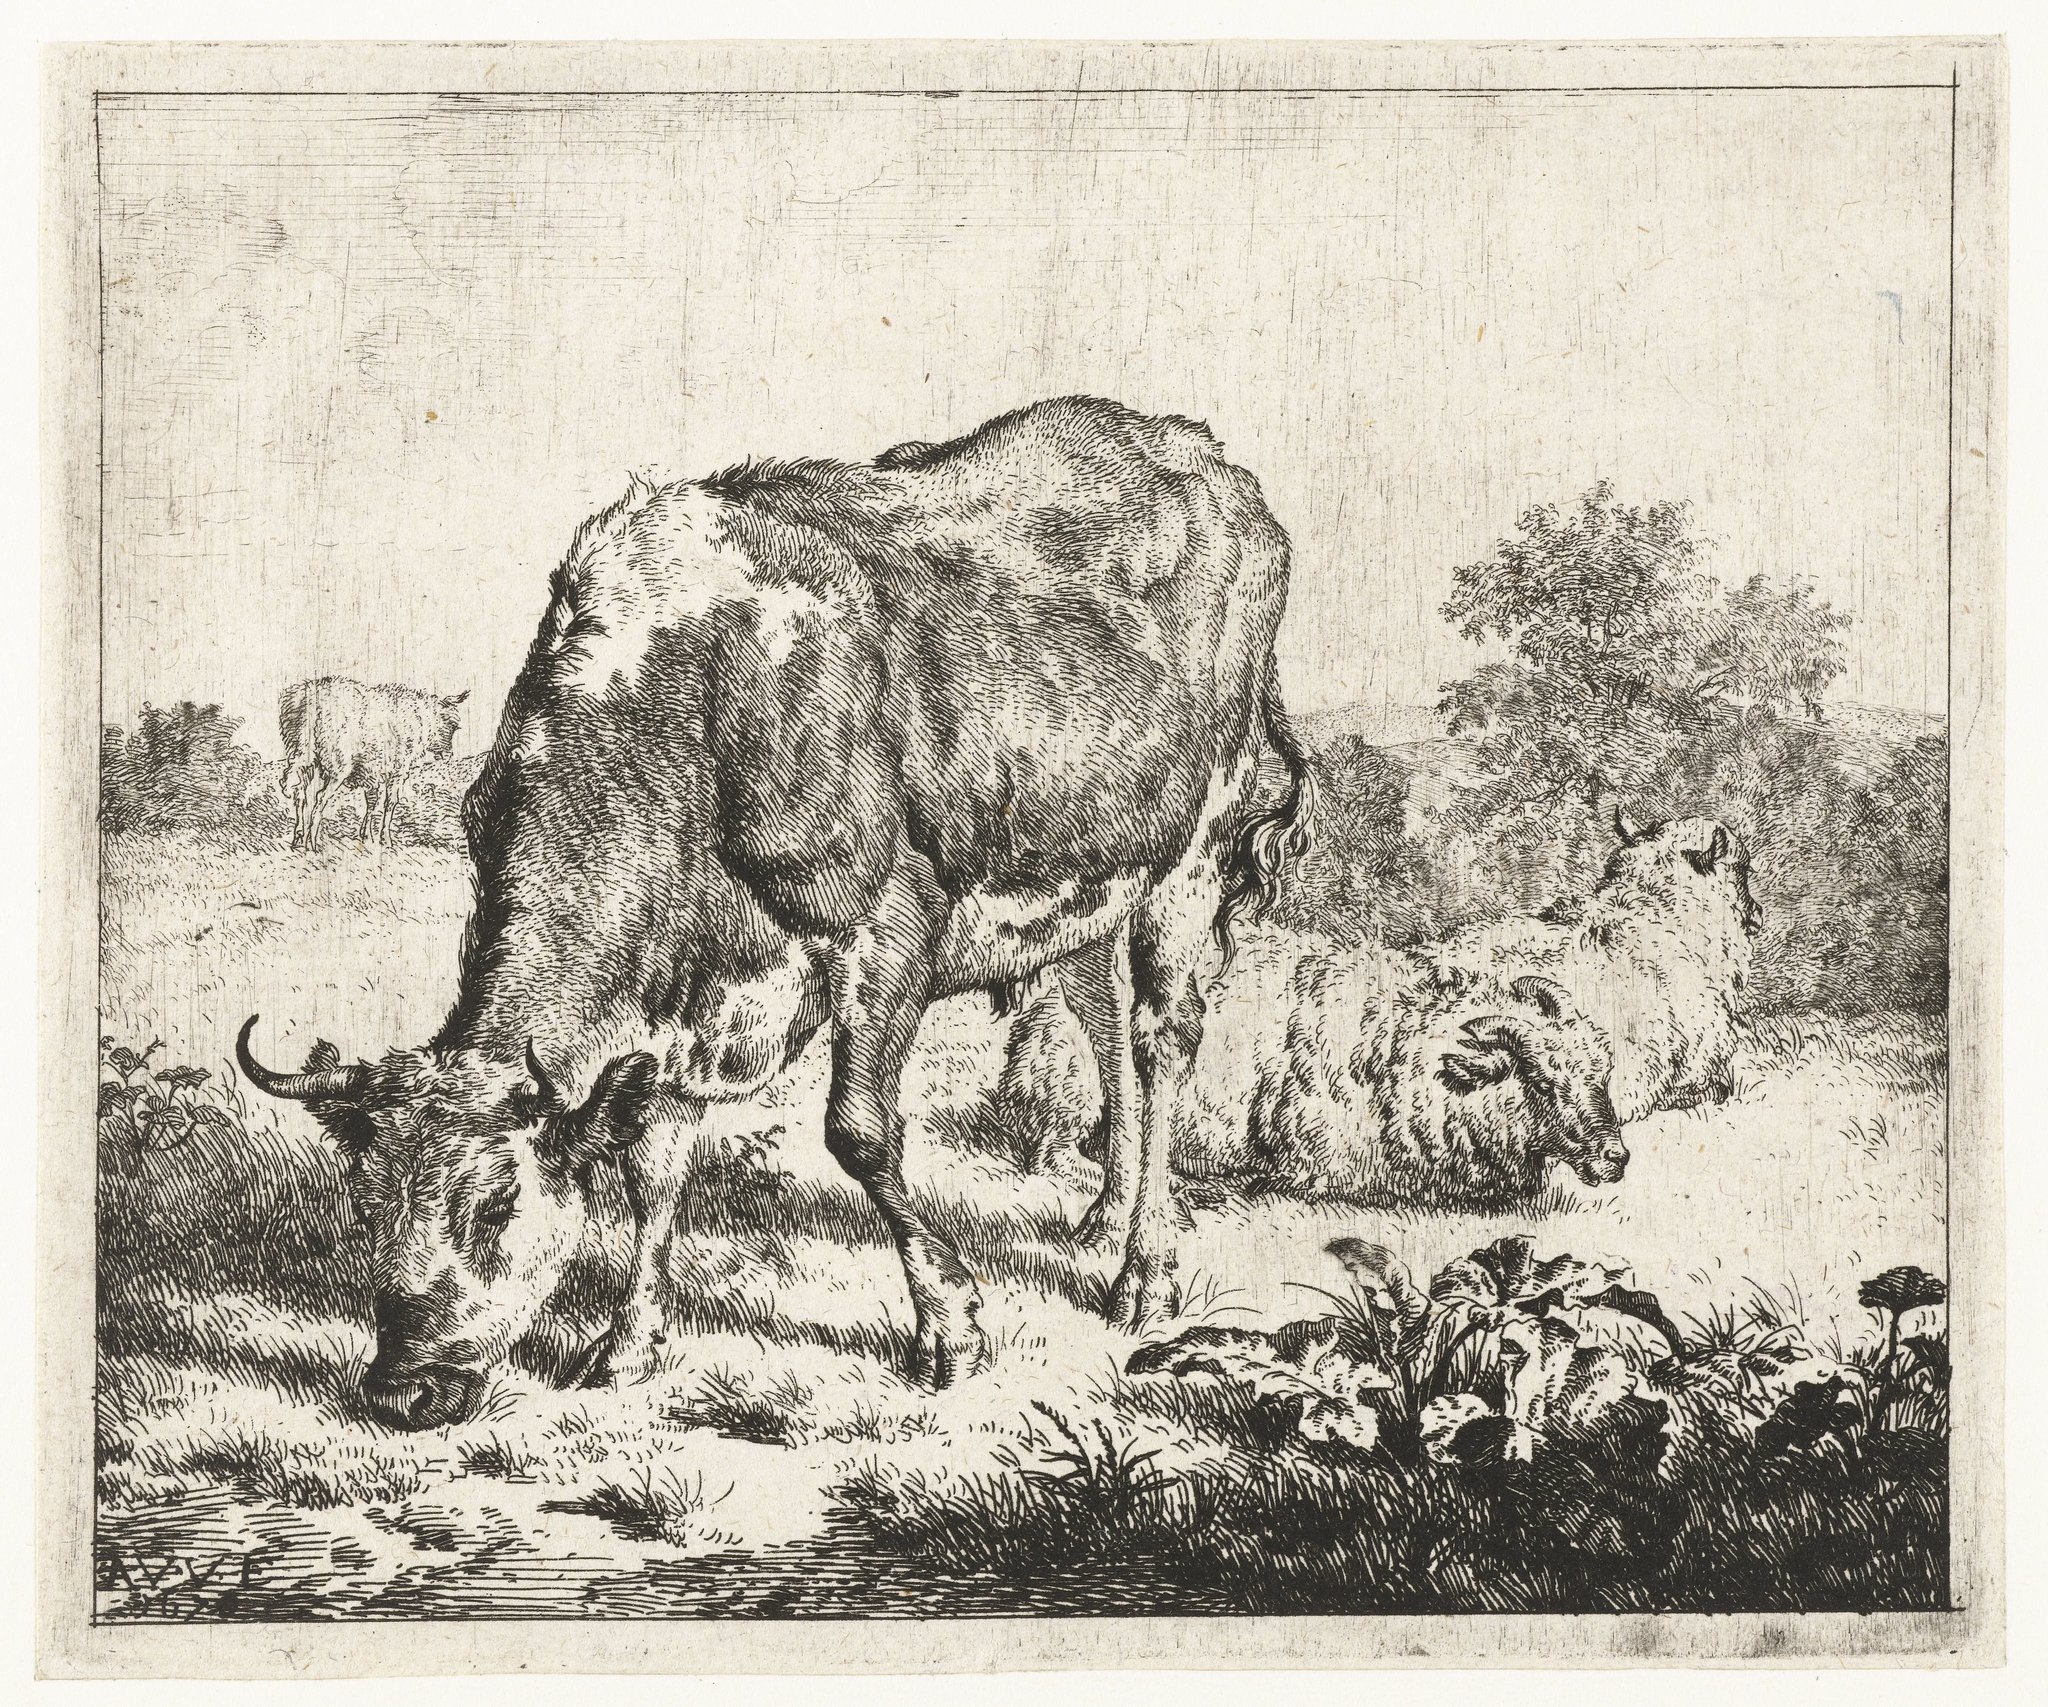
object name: print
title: Bonte stier met drie schapen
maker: adriaen van de velde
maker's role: draughtsman, painter, print maker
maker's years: 1636-1672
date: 1670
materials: paper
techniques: etching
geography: amsterdam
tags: bull, sheep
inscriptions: collector's mark: Lugt 240